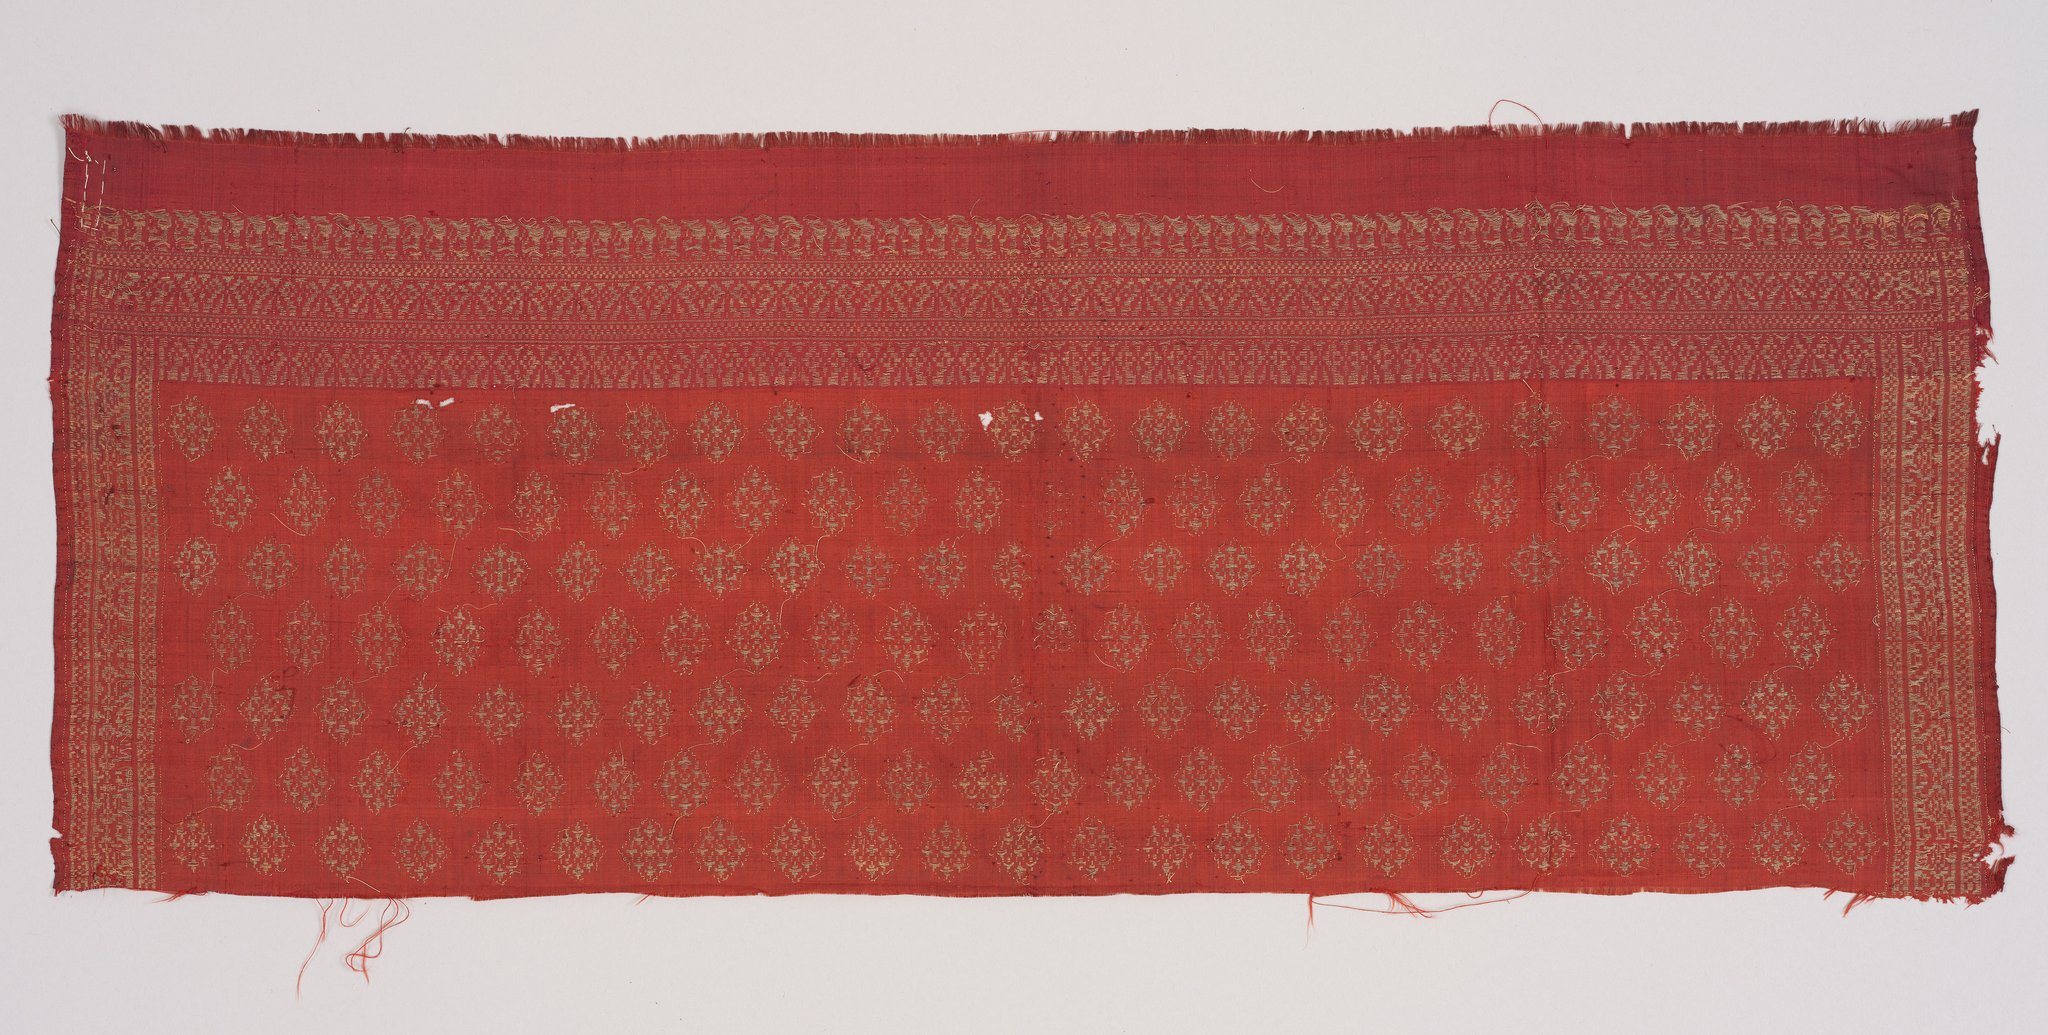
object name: scarf fragment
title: Fragment of Scarf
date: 1701-1800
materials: gold thread, silk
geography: morocco